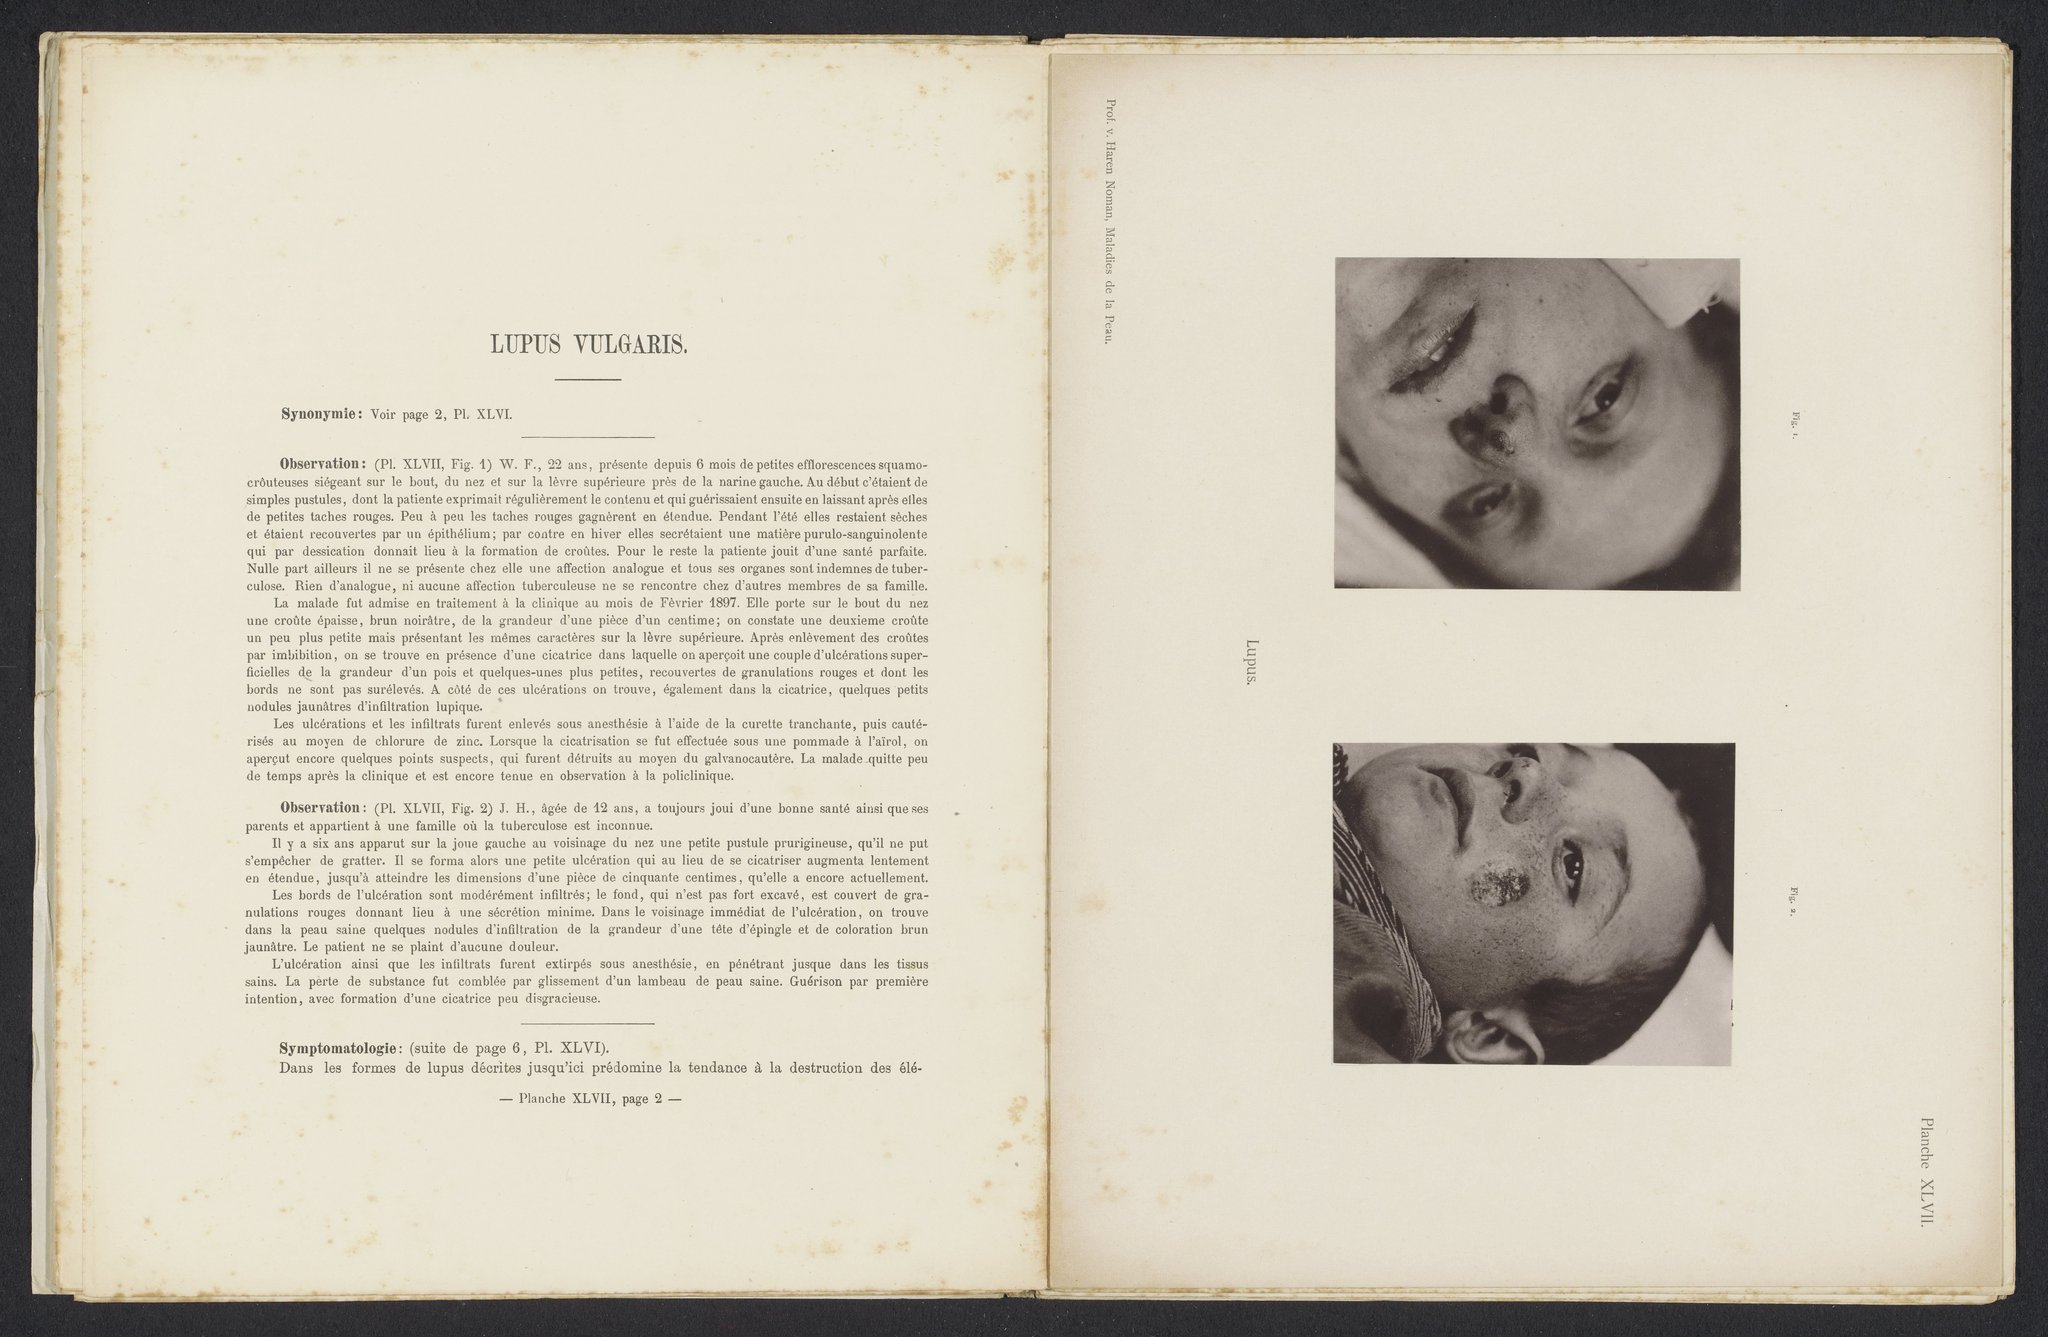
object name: page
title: Lupus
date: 1887-1897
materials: paper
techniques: photograph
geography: amsterdam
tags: face, skin and venereal diseases, child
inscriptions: number: ‘Planche XLVII. / Fig. 1. / Fig. 2.’